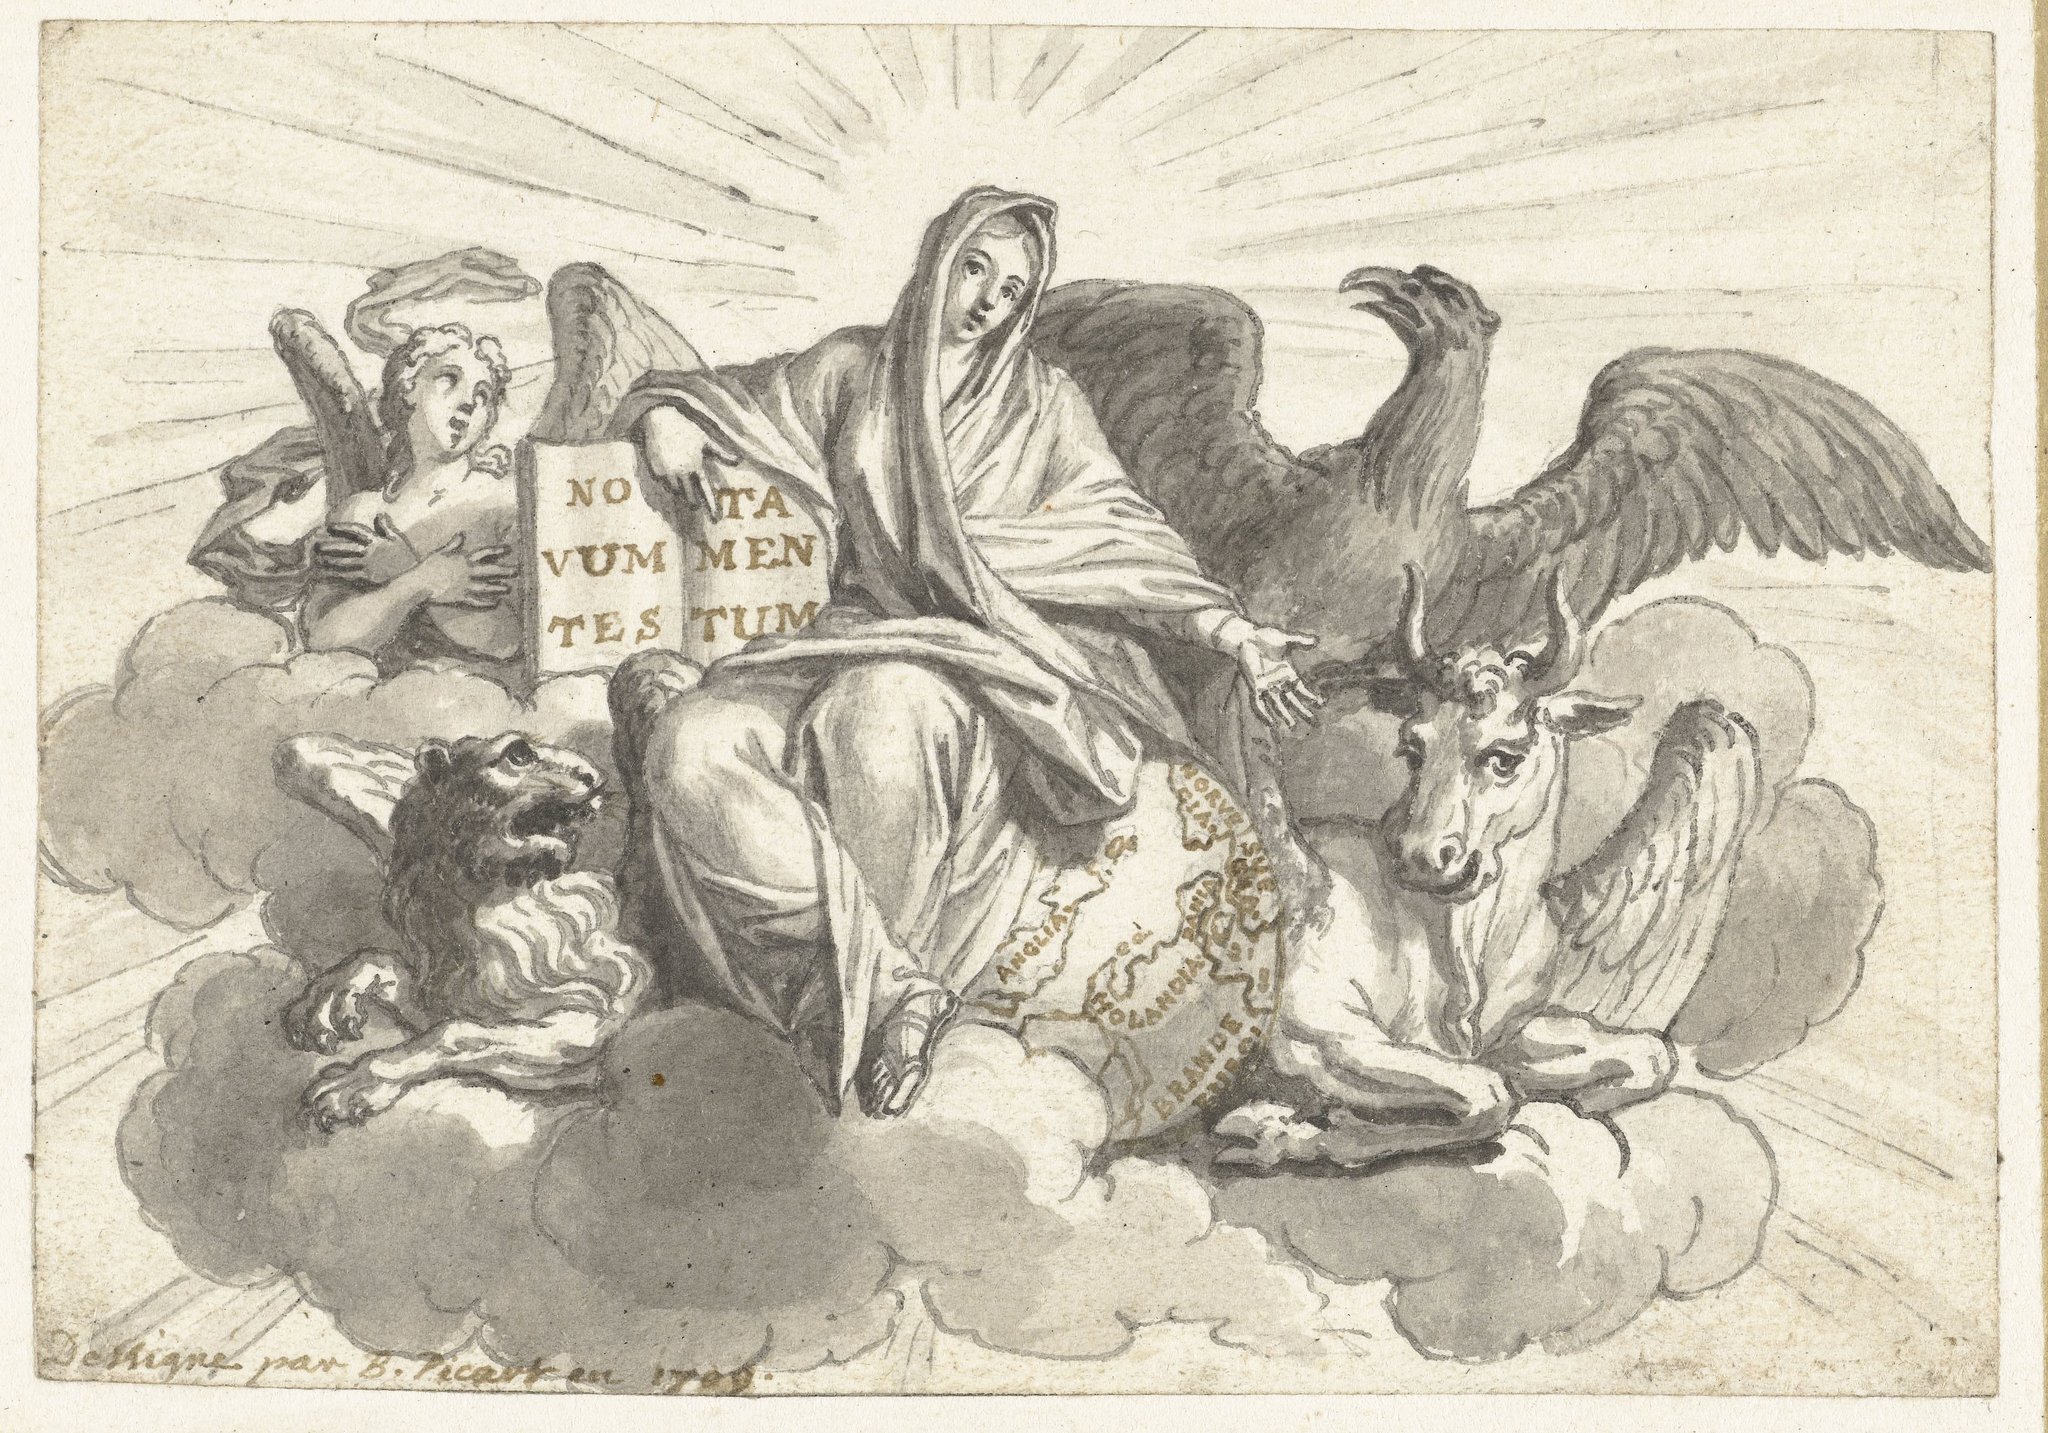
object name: drawing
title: Vignet met het Nieuwe Testament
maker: bernard picart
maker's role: draughtsman, print maker, publisher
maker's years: 1673-1733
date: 1709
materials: ink, paper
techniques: brush, pen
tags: mary (without the christ-child), the four symbols of the evangelists, 'the apocalyptic beasts'